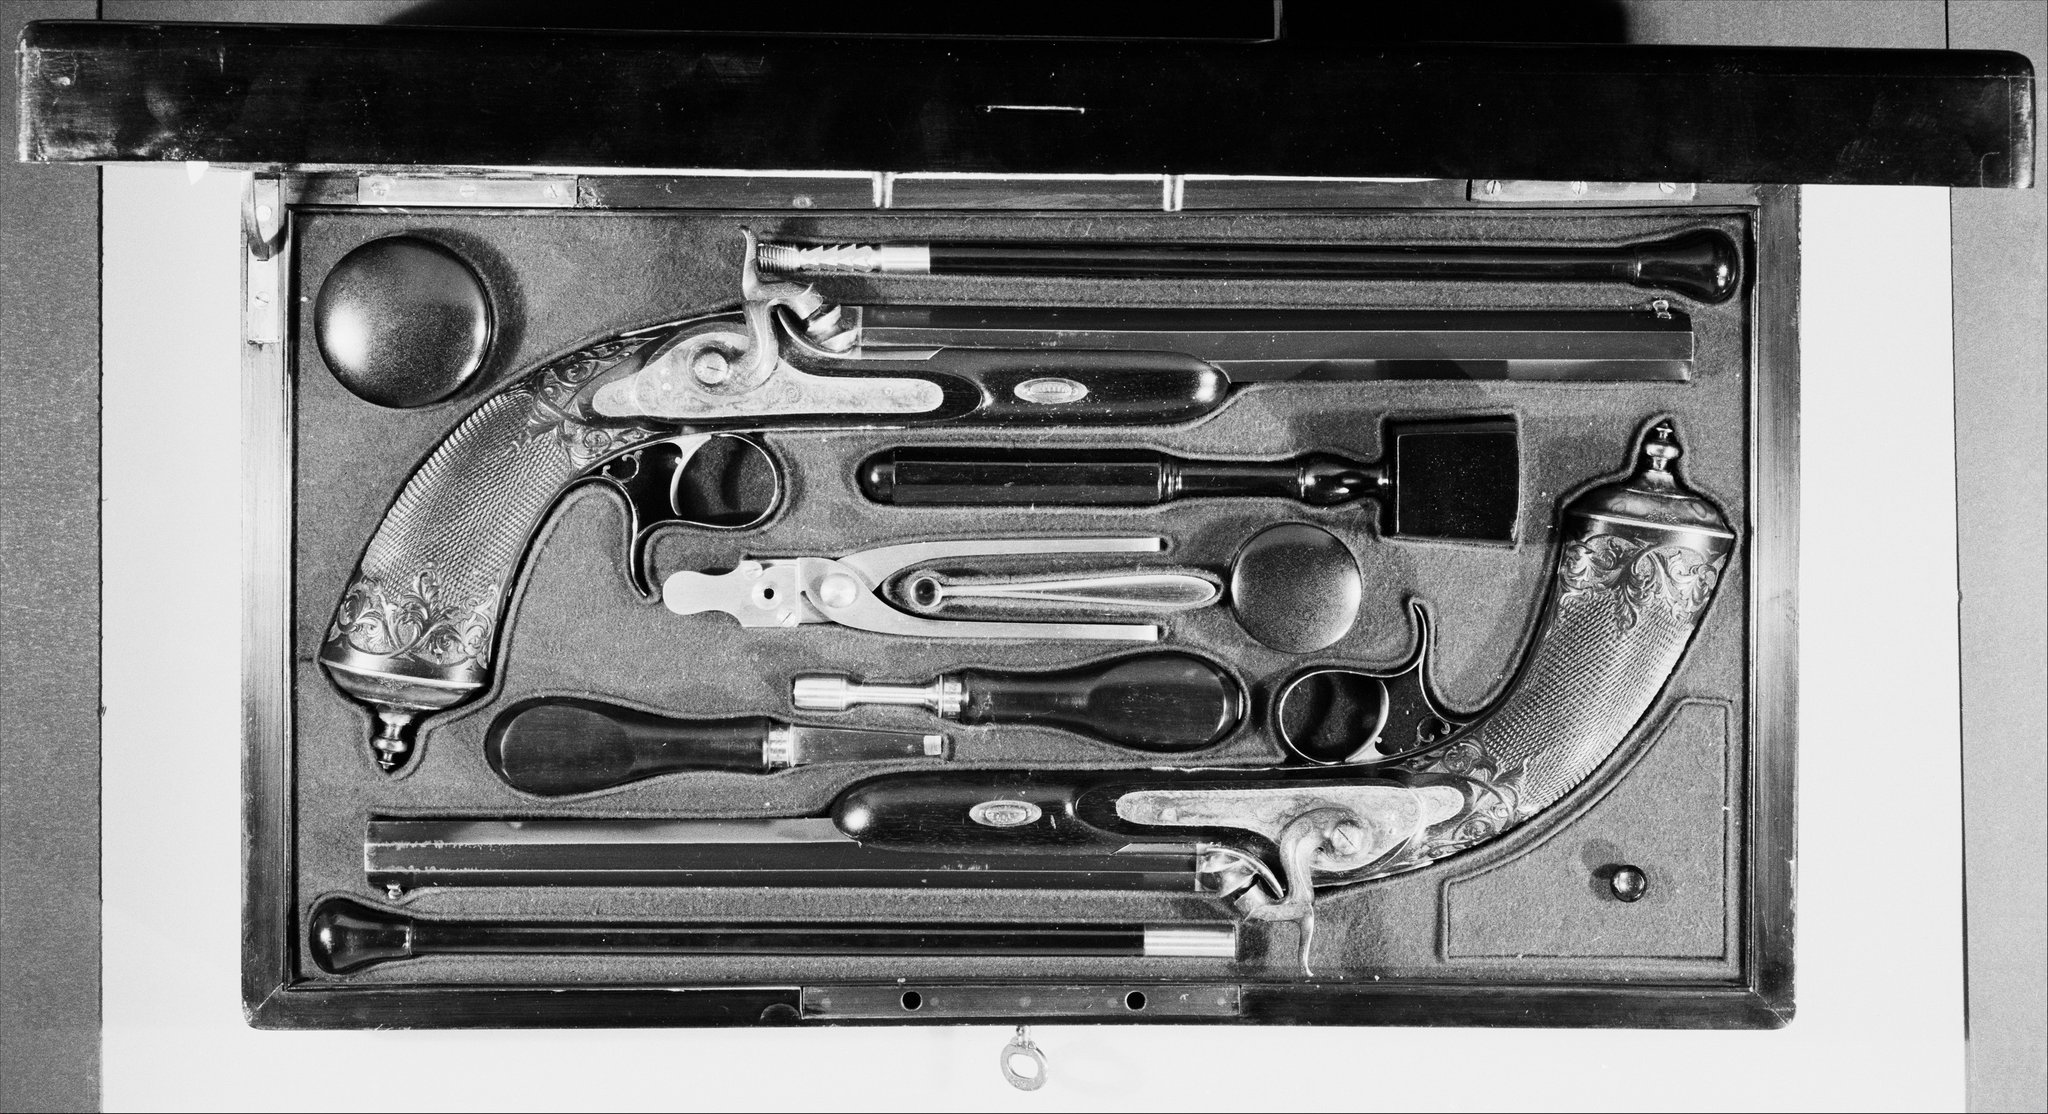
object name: cased pair of percussion pistol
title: Cased Pair of Percussion Pistols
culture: french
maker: louis-julien gastinne-renette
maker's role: artist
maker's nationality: french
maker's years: 1812-1885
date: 1850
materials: brass, gold, steel, velvet, wood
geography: france